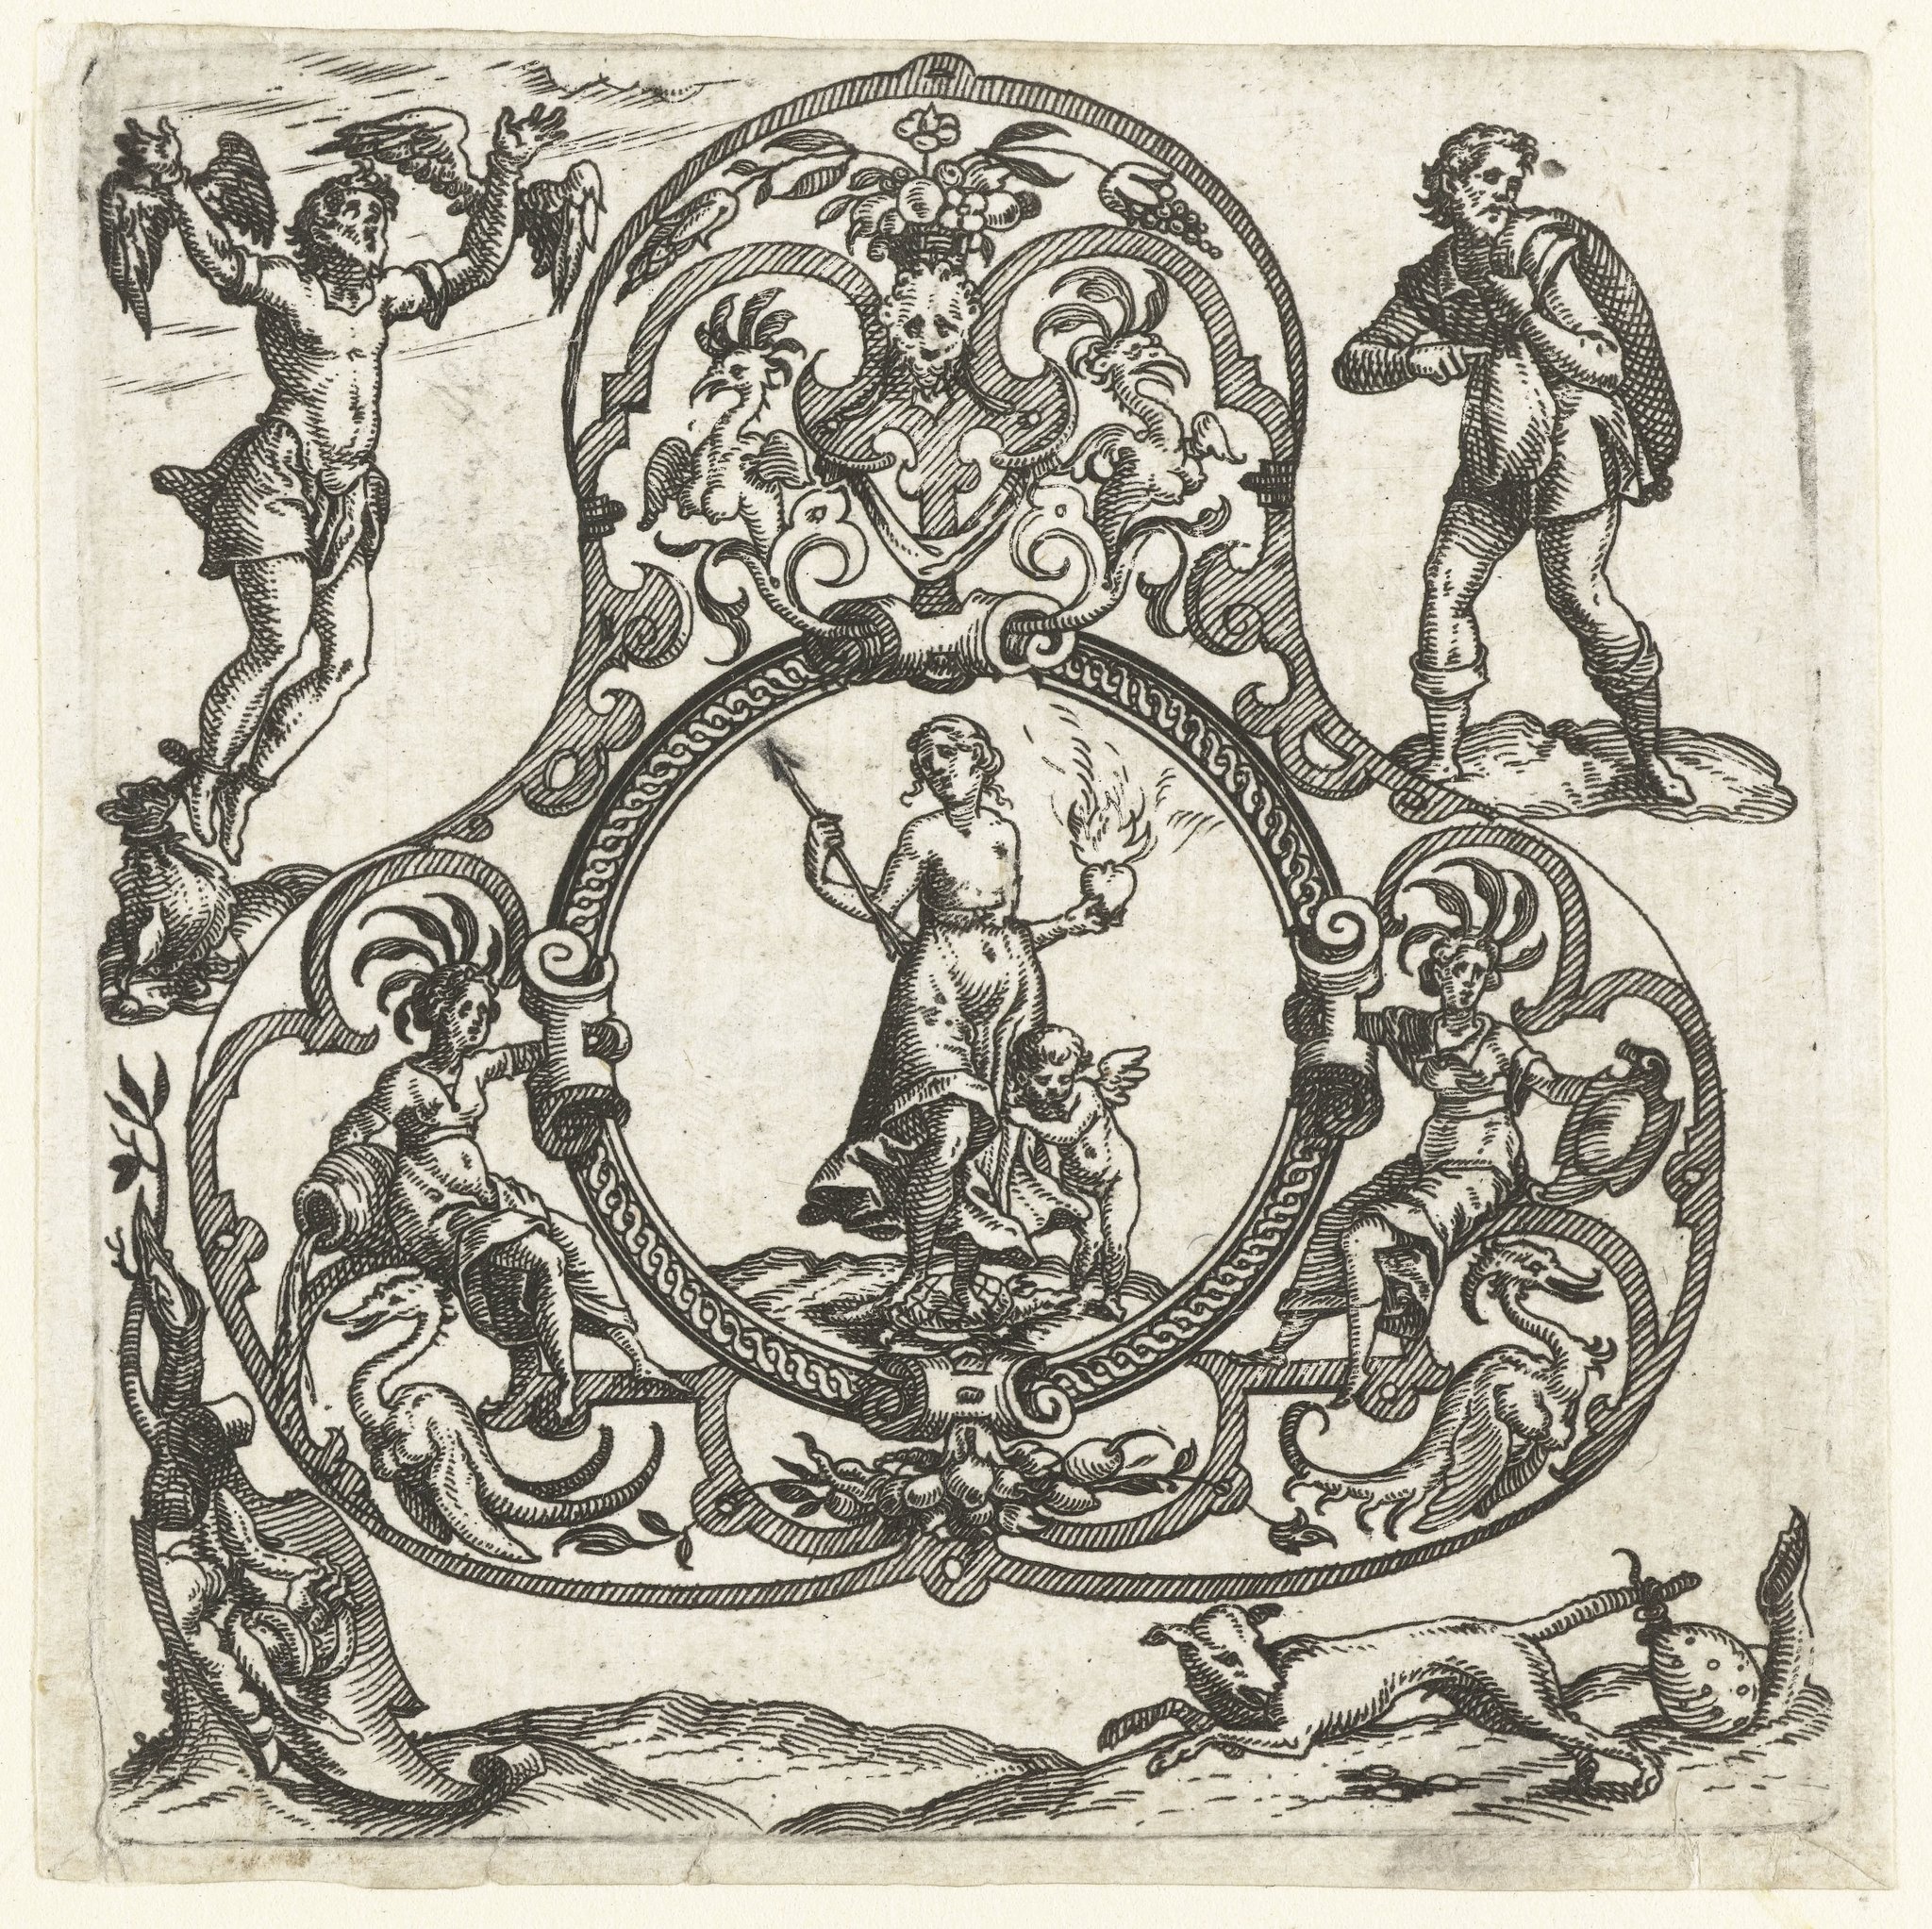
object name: ornament print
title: Peervormige hangers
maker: dietrich meyer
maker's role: painter, print maker, publisher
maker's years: 1572-1658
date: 1600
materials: paper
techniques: etching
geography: zurich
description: Linksboven een man met vleugels aan zijn polsen die probeert te vliegen, maar wordt gehinderd door een gewicht aan zijn voeten. Rechtsboven een scène uit de fabel van de man met de twee tassen. Linksonder een wapenschild met een hand die een serpent vasthoudt en rechtsonder een hond met een tas aan zijn staart. Een van 8 ongenummerde bladen uit een serie van 12 met peervormige hangers met grotesken, vogels, vissen en guirlandes, geplaatst in een structuur van rolwerk en Schweifwerk.